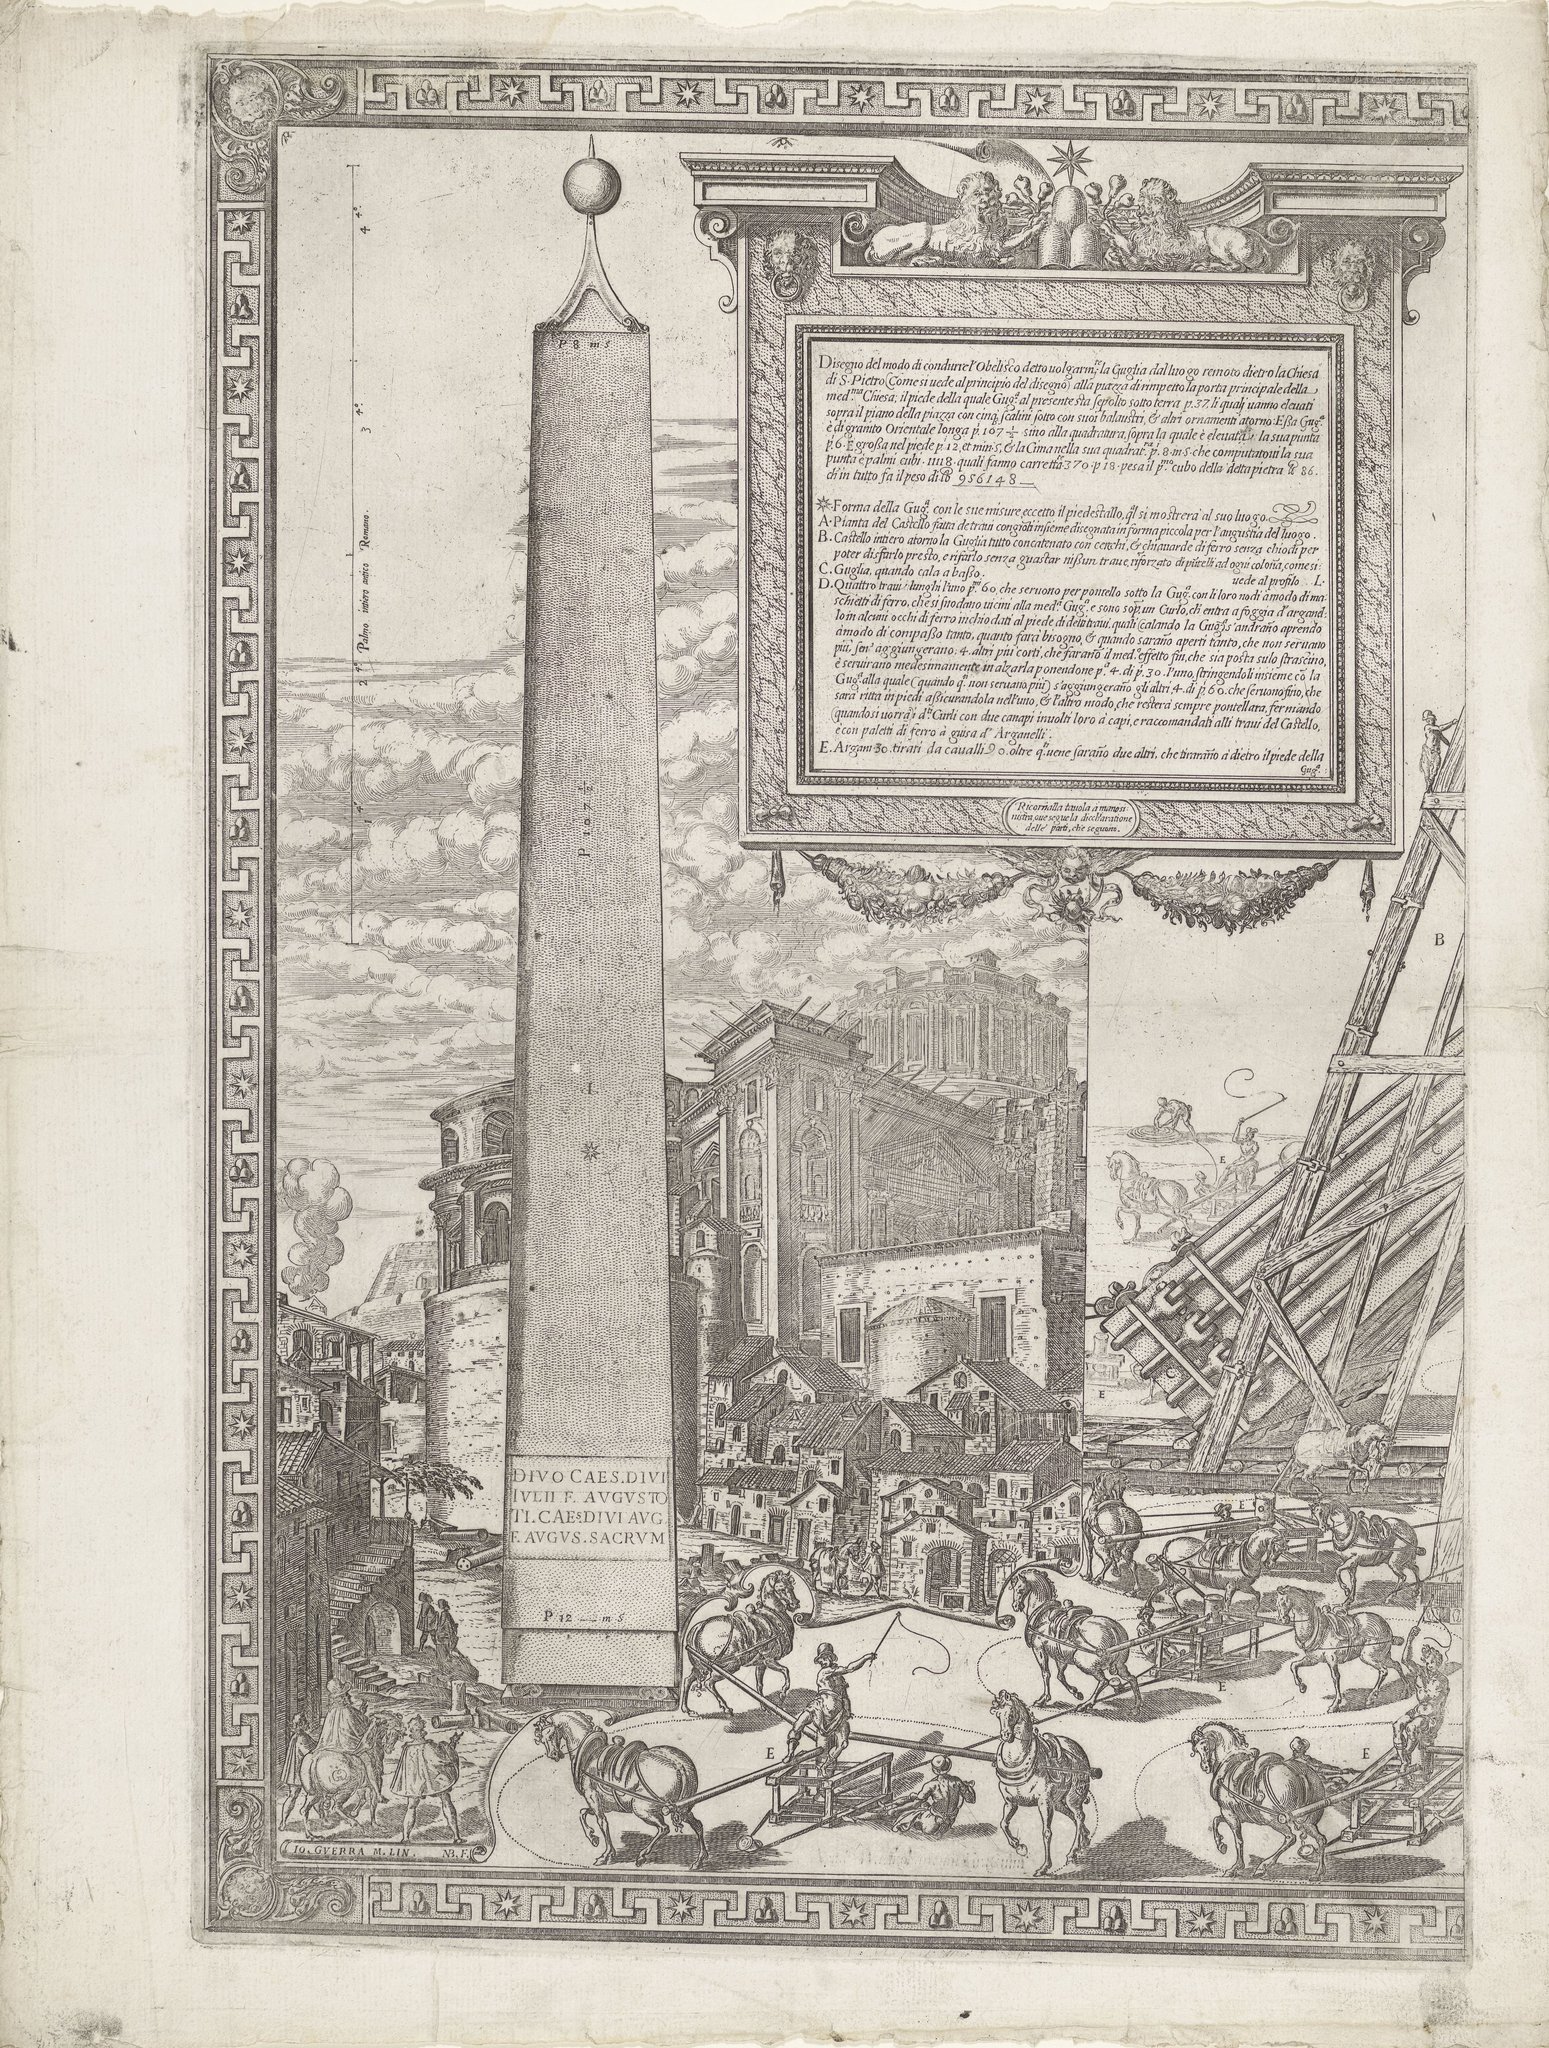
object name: print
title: De oprichting van de obelisk op het St. Pietersplein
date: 1586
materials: paper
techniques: etching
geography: rome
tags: sixtus v, switzerland, domenico fontana, obelisk, needle, roman catholic church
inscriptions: collector's mark: Lugt 2228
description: Links de Vaticaanse Obelisk die rechtop staat, bekroond met een koperen bol. Rechts mannen en paarden die de Vaticaanse Obelisk op zijn nieuwe plek, het St. Pietersplein, rechtop zetten met behulp van een houten stellage. Rechtsboven een sierlijst met tekst. Voorstelling gevat in een sierlijst.